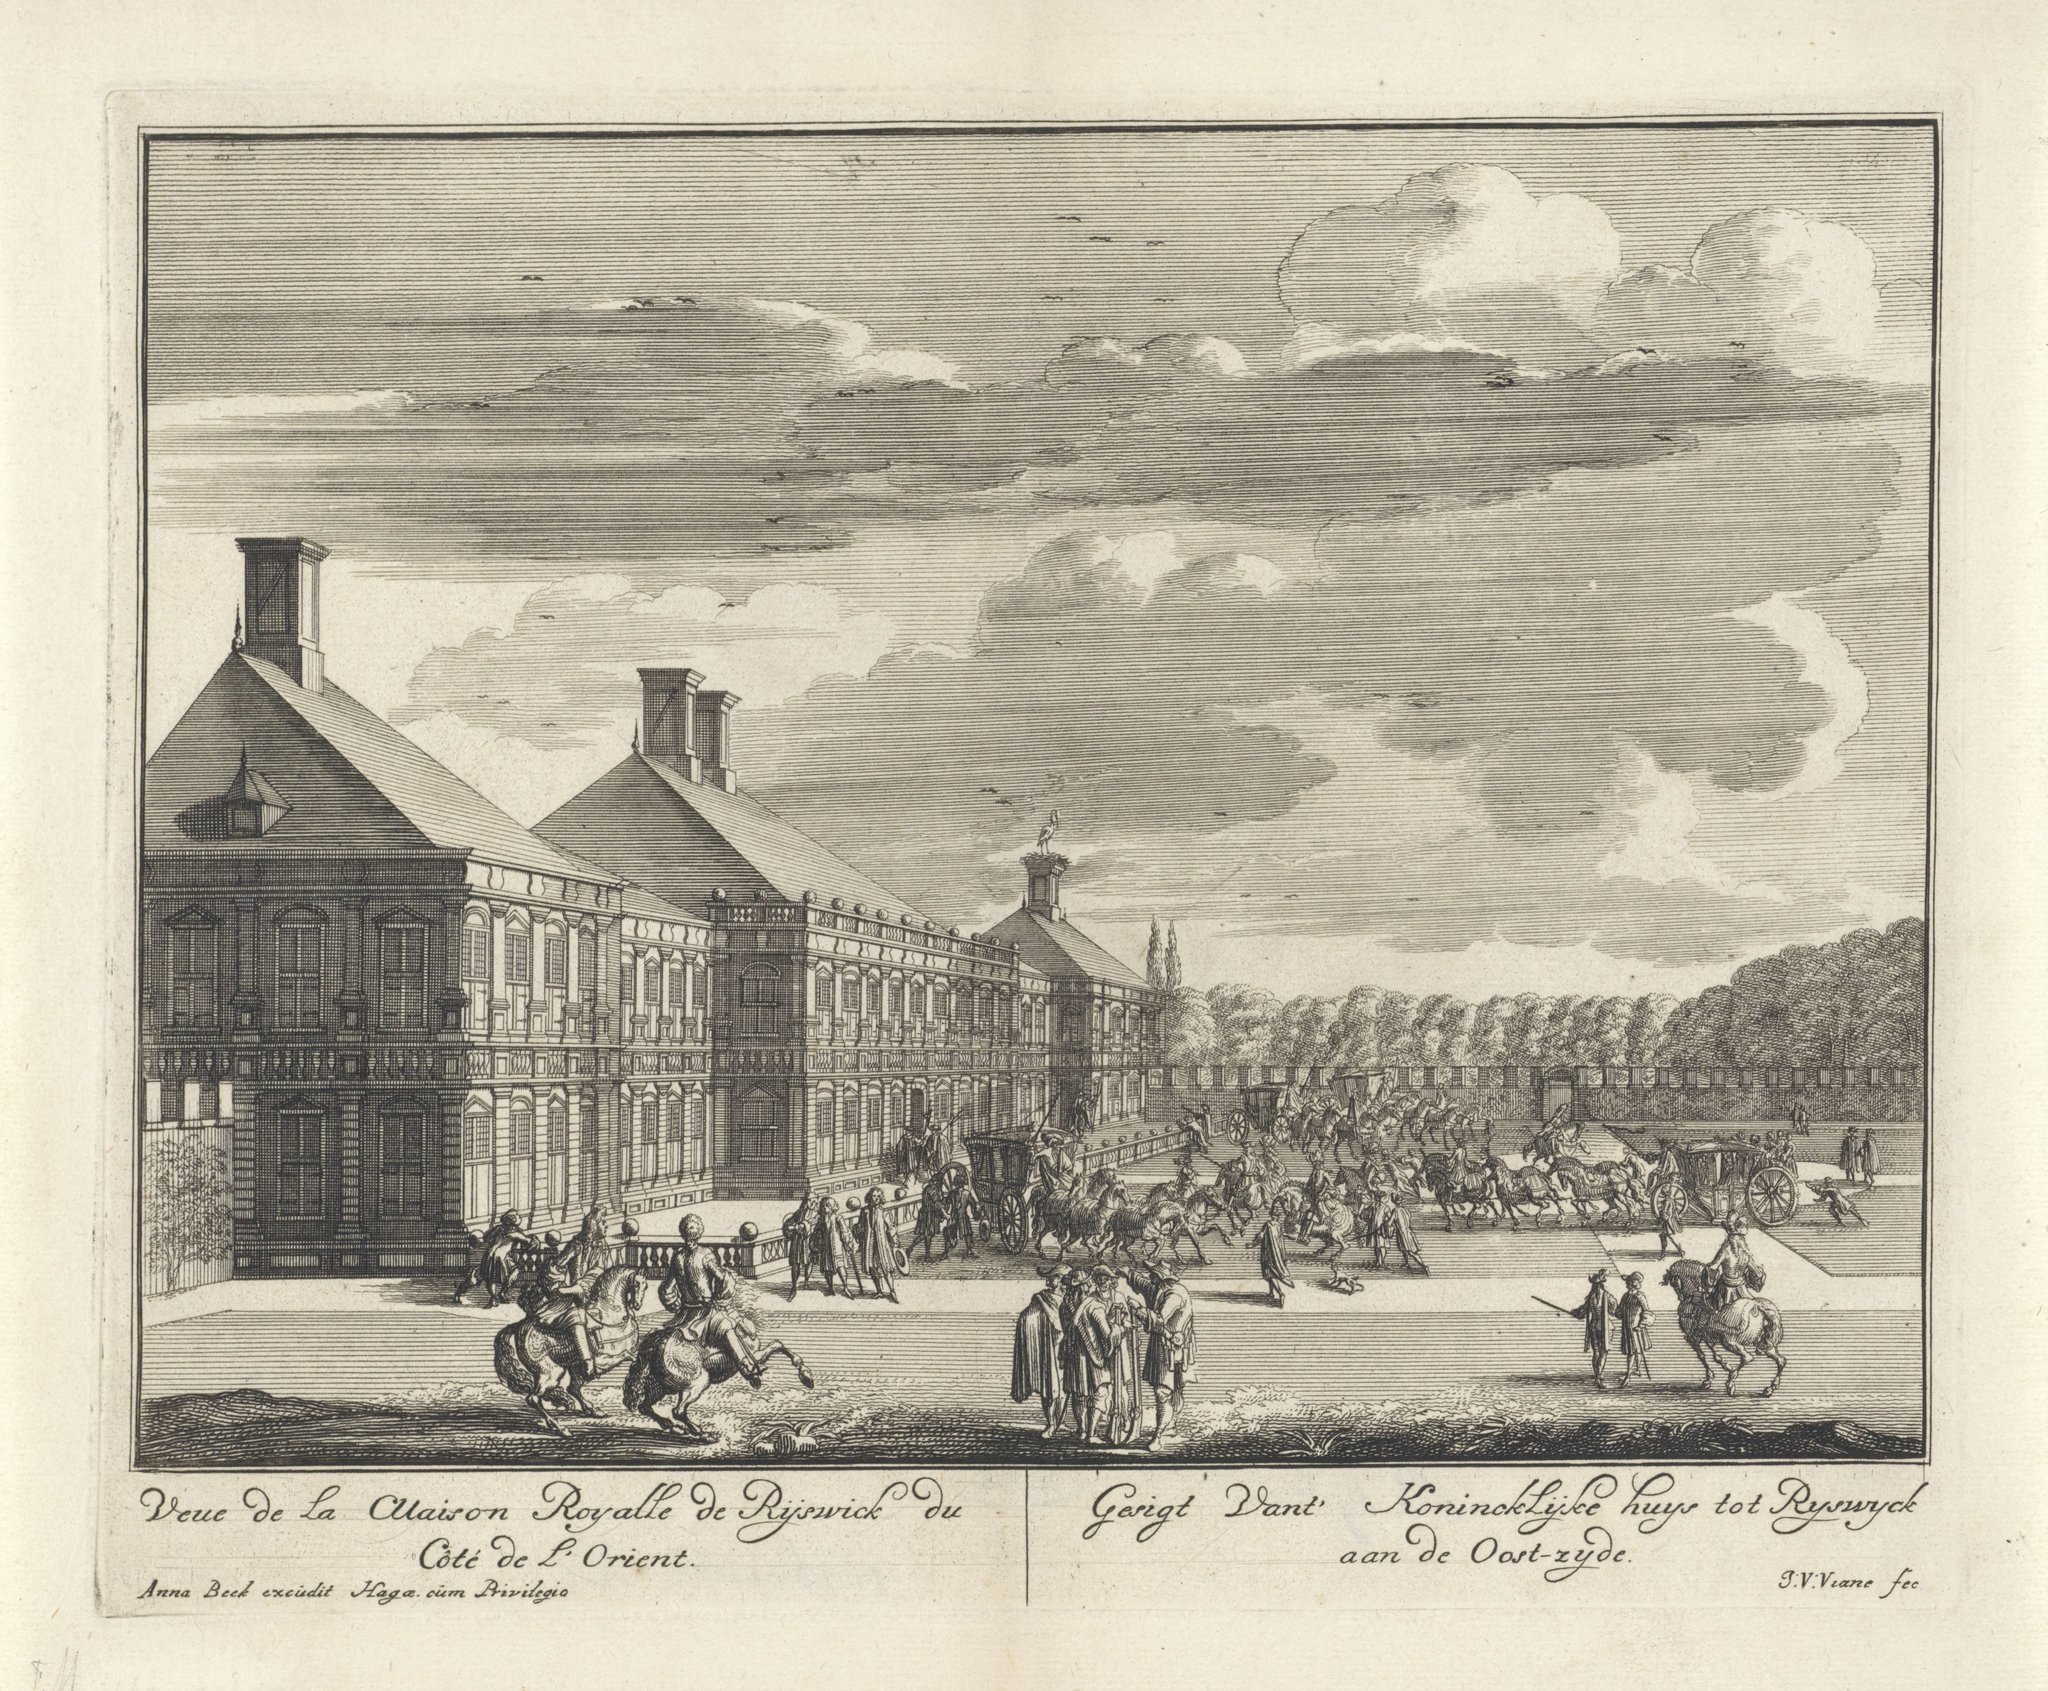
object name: print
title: Serie van vijftien prenten over het Huis ter Nieuburch in Rijswijk en de vredesonderhandelingen, 1697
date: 1697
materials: paper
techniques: etching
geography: northern netherlands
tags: palace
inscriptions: collector's mark: Lugt 2228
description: Gezicht op het Huis ter Nieuburch in Rijswijk, oostzijde. In het onderschrift de twee titels in het Frans en Nederlands. Onderdeel (prent 3) van de serie van vijftien prenten over het Huis ter Nieuburch in Rijswijk en de daar gehouden vredesonderhandelingen resulterend in de Vrede van Rijswijk gesloten op 20 september 1697.